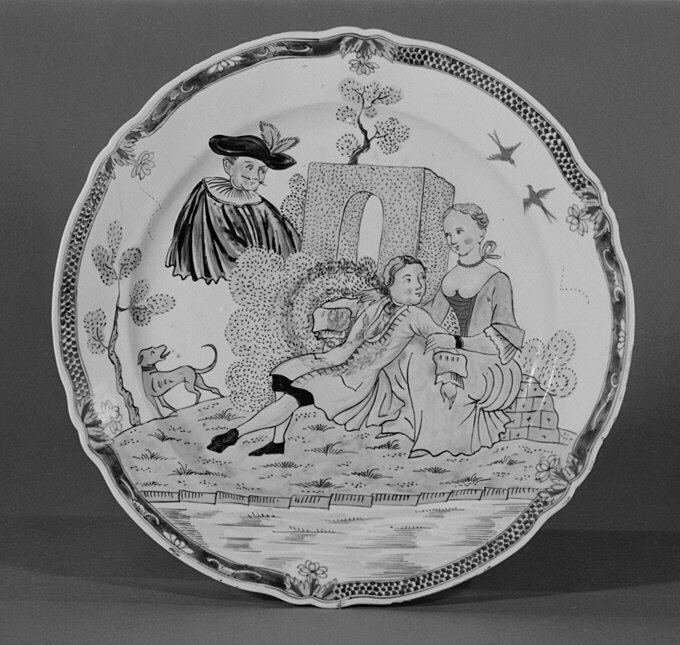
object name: platter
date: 1701-1800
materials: hard paste porcelain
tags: girls,men,women,dogs